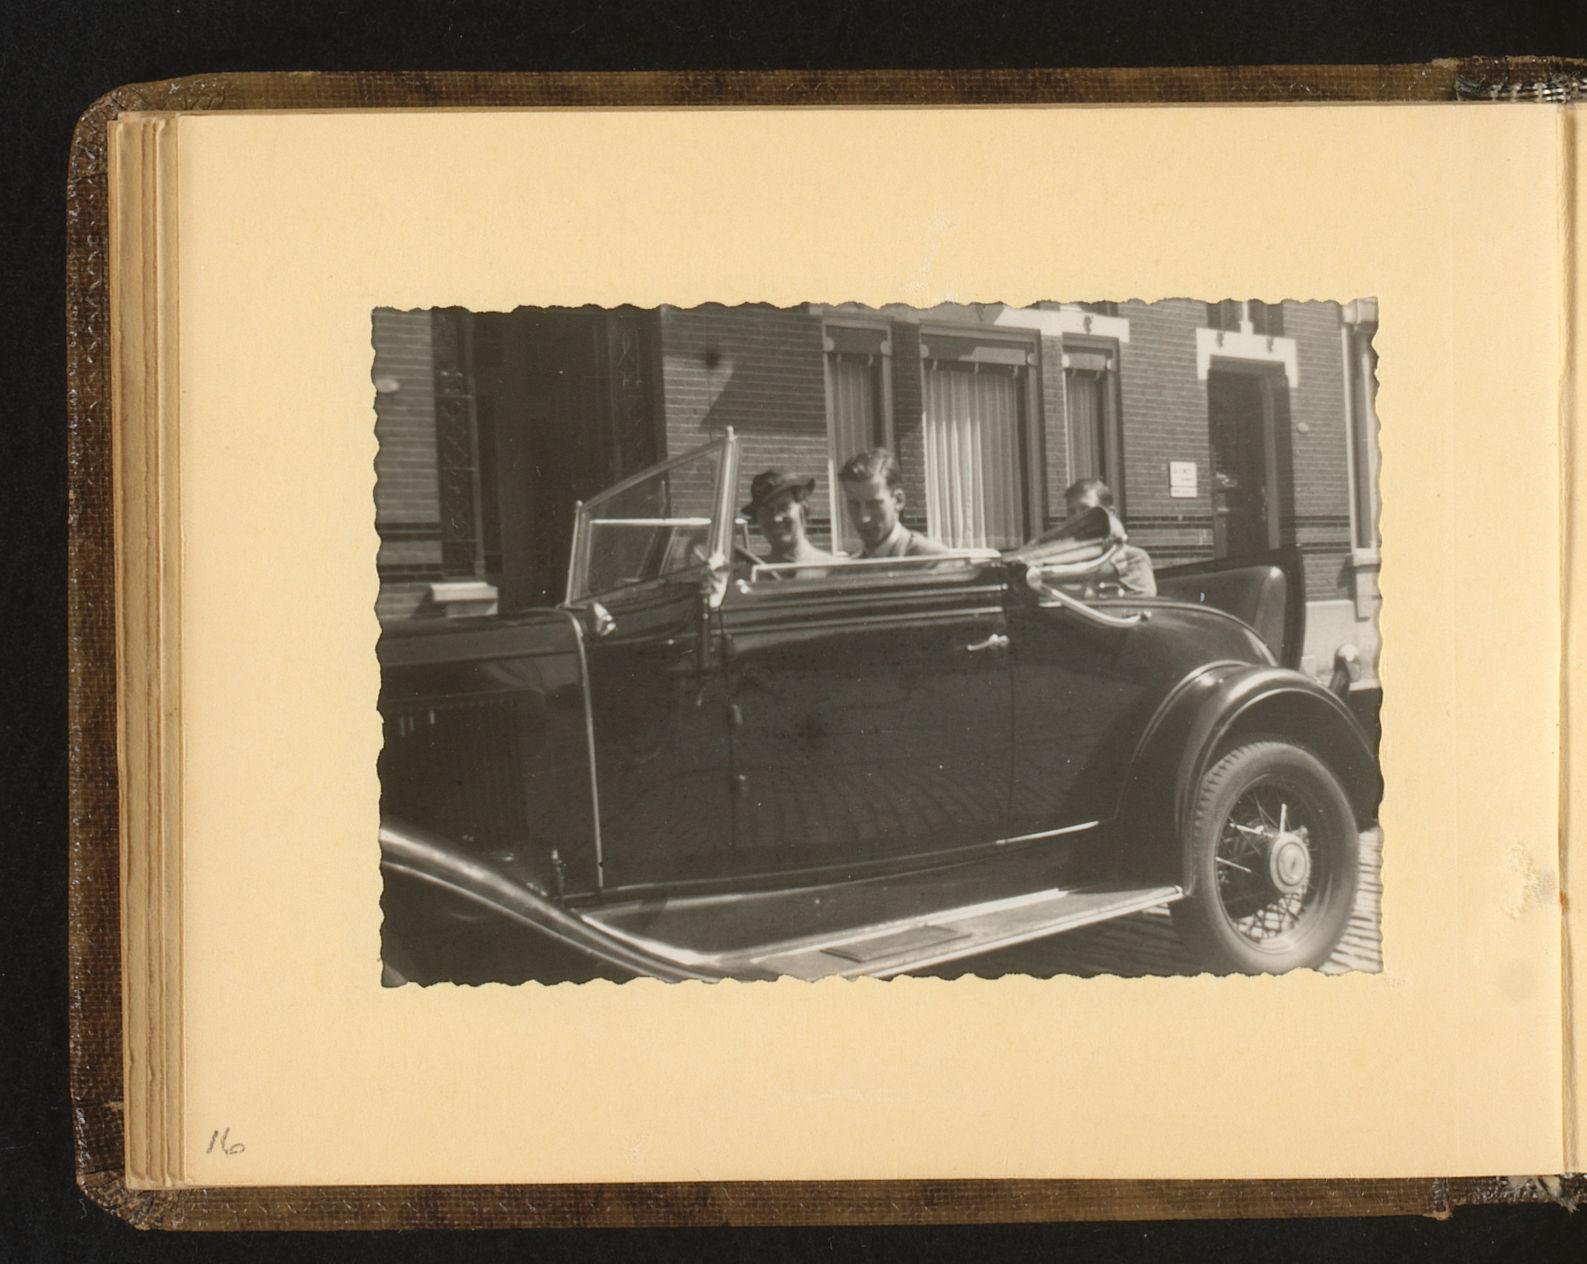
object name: photograph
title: Man en vrouw in auto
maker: Anonymous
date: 1938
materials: cardboard, photographic support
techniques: gelatin silver print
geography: rotterdam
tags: family life at home, automobile, rotterdam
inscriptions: inscription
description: Albumblad met een foto van een man en een vrouw in een auto. Onderdeel van het familiealbum 1938-1939.